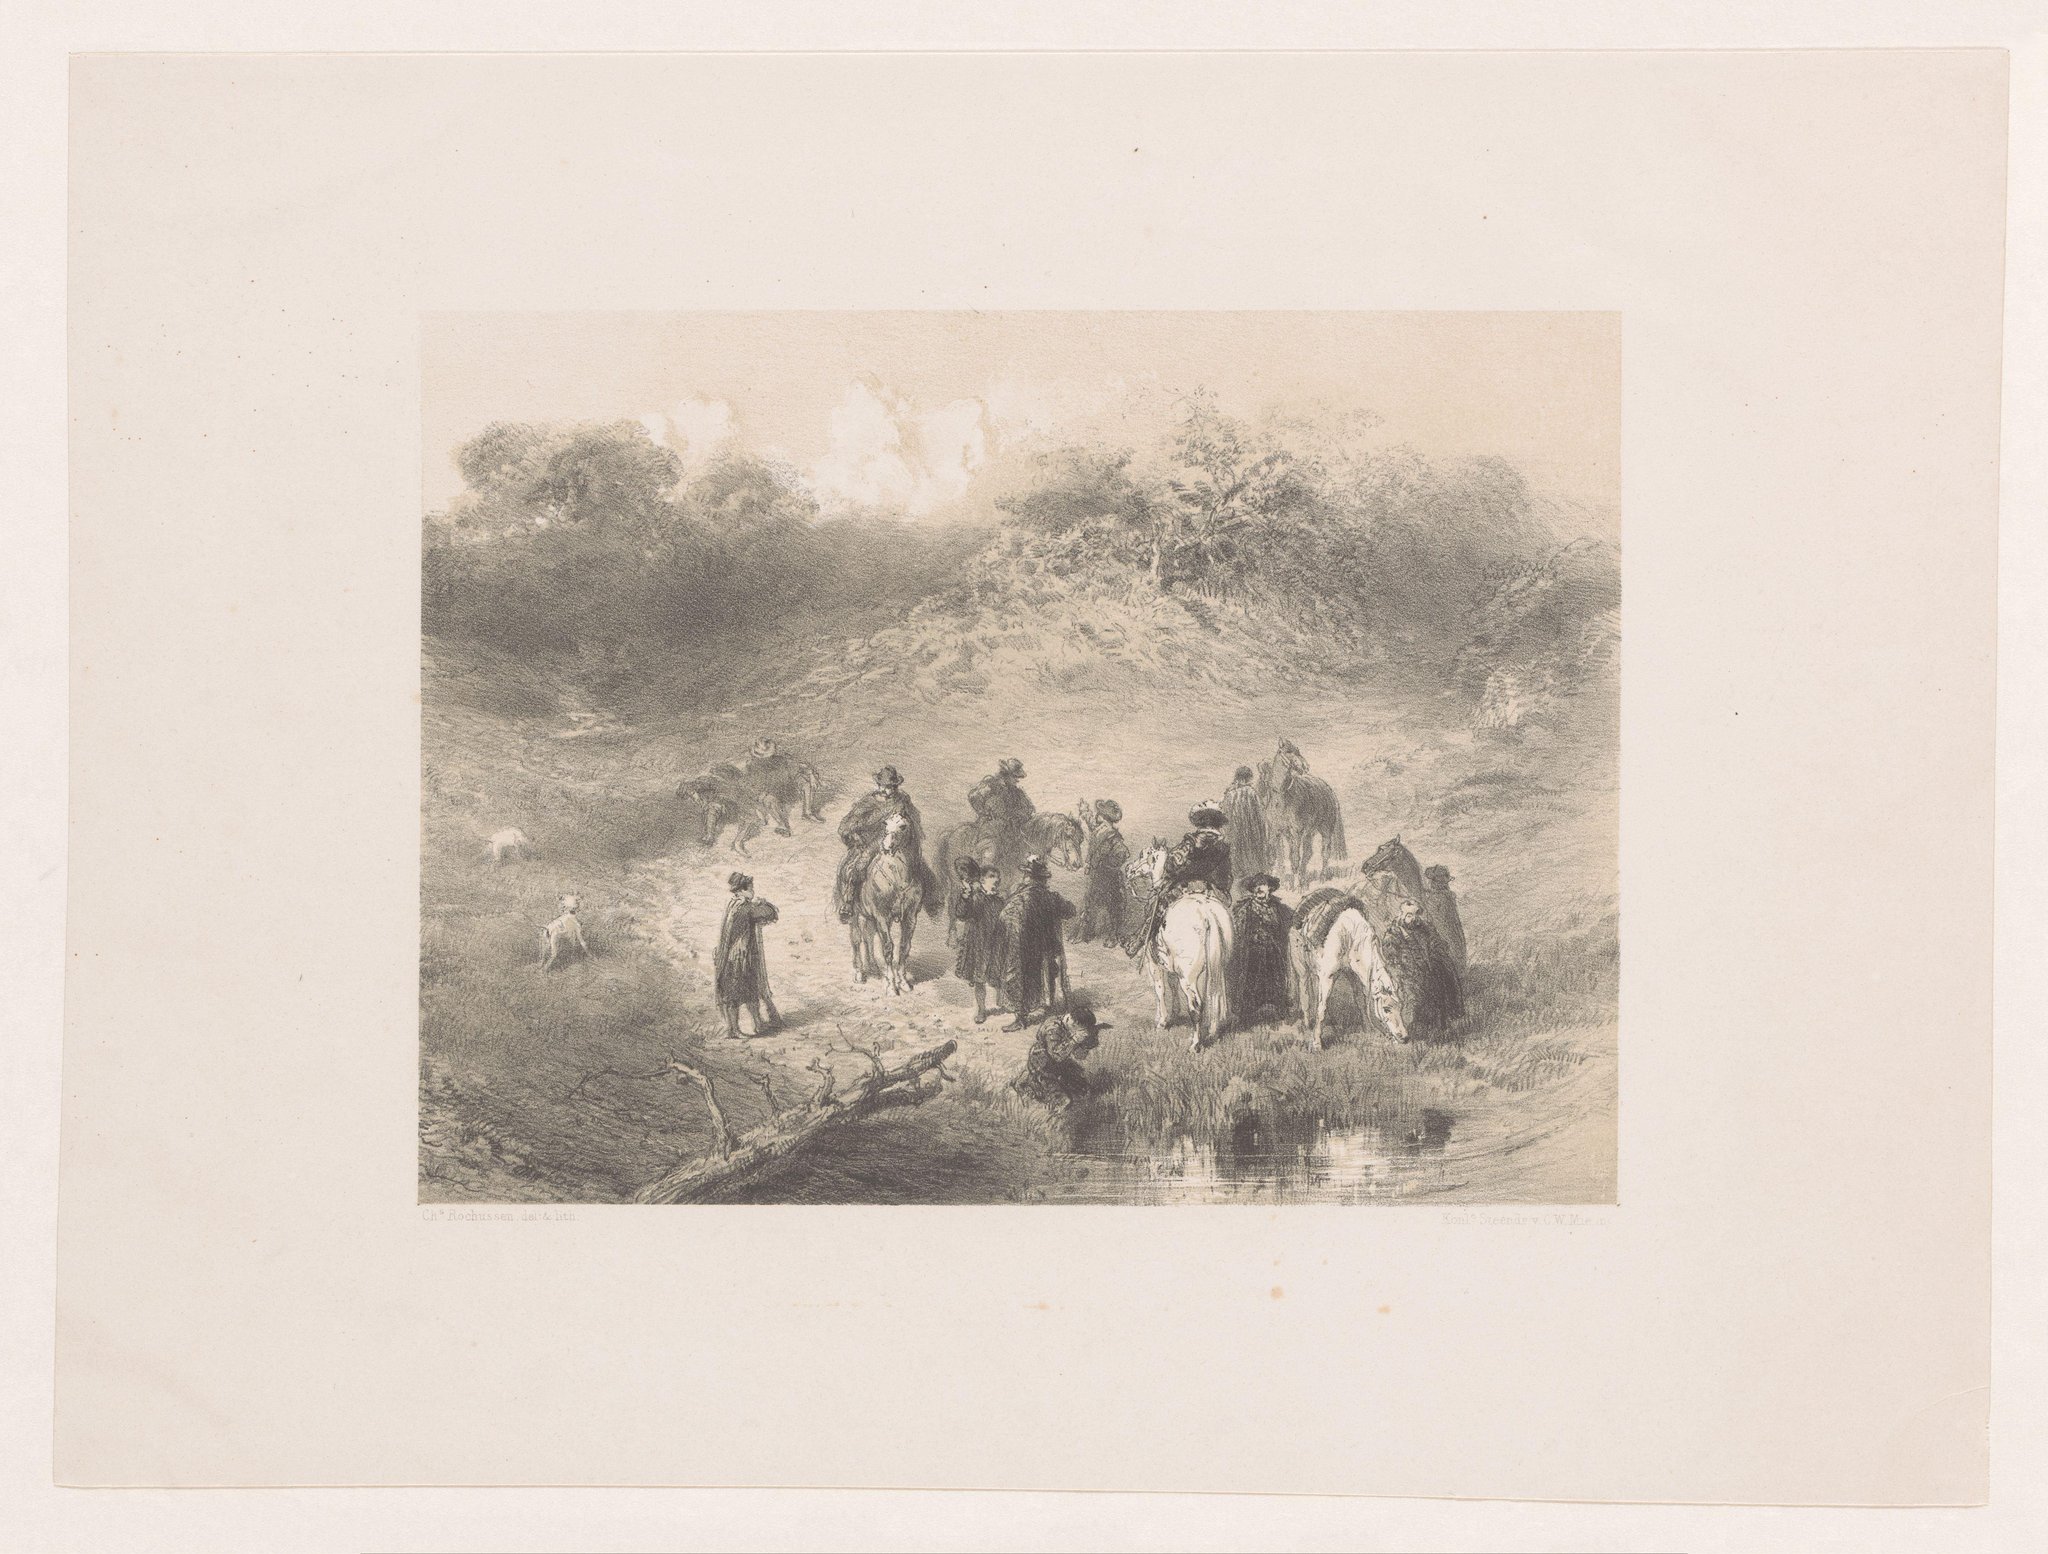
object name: print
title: Ruiters in duinlandschap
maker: charles rochussen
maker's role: draughtsman, painter, print maker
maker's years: 1814-1894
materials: paper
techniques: tone lithography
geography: the hague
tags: riding a horse, ass, or mule; rider, horseman, dunes (sea not visible); in the dunes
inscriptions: collector's mark: Lugt 2228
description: Een groep ruiters staat in een duinachtig landschap bij een plas.